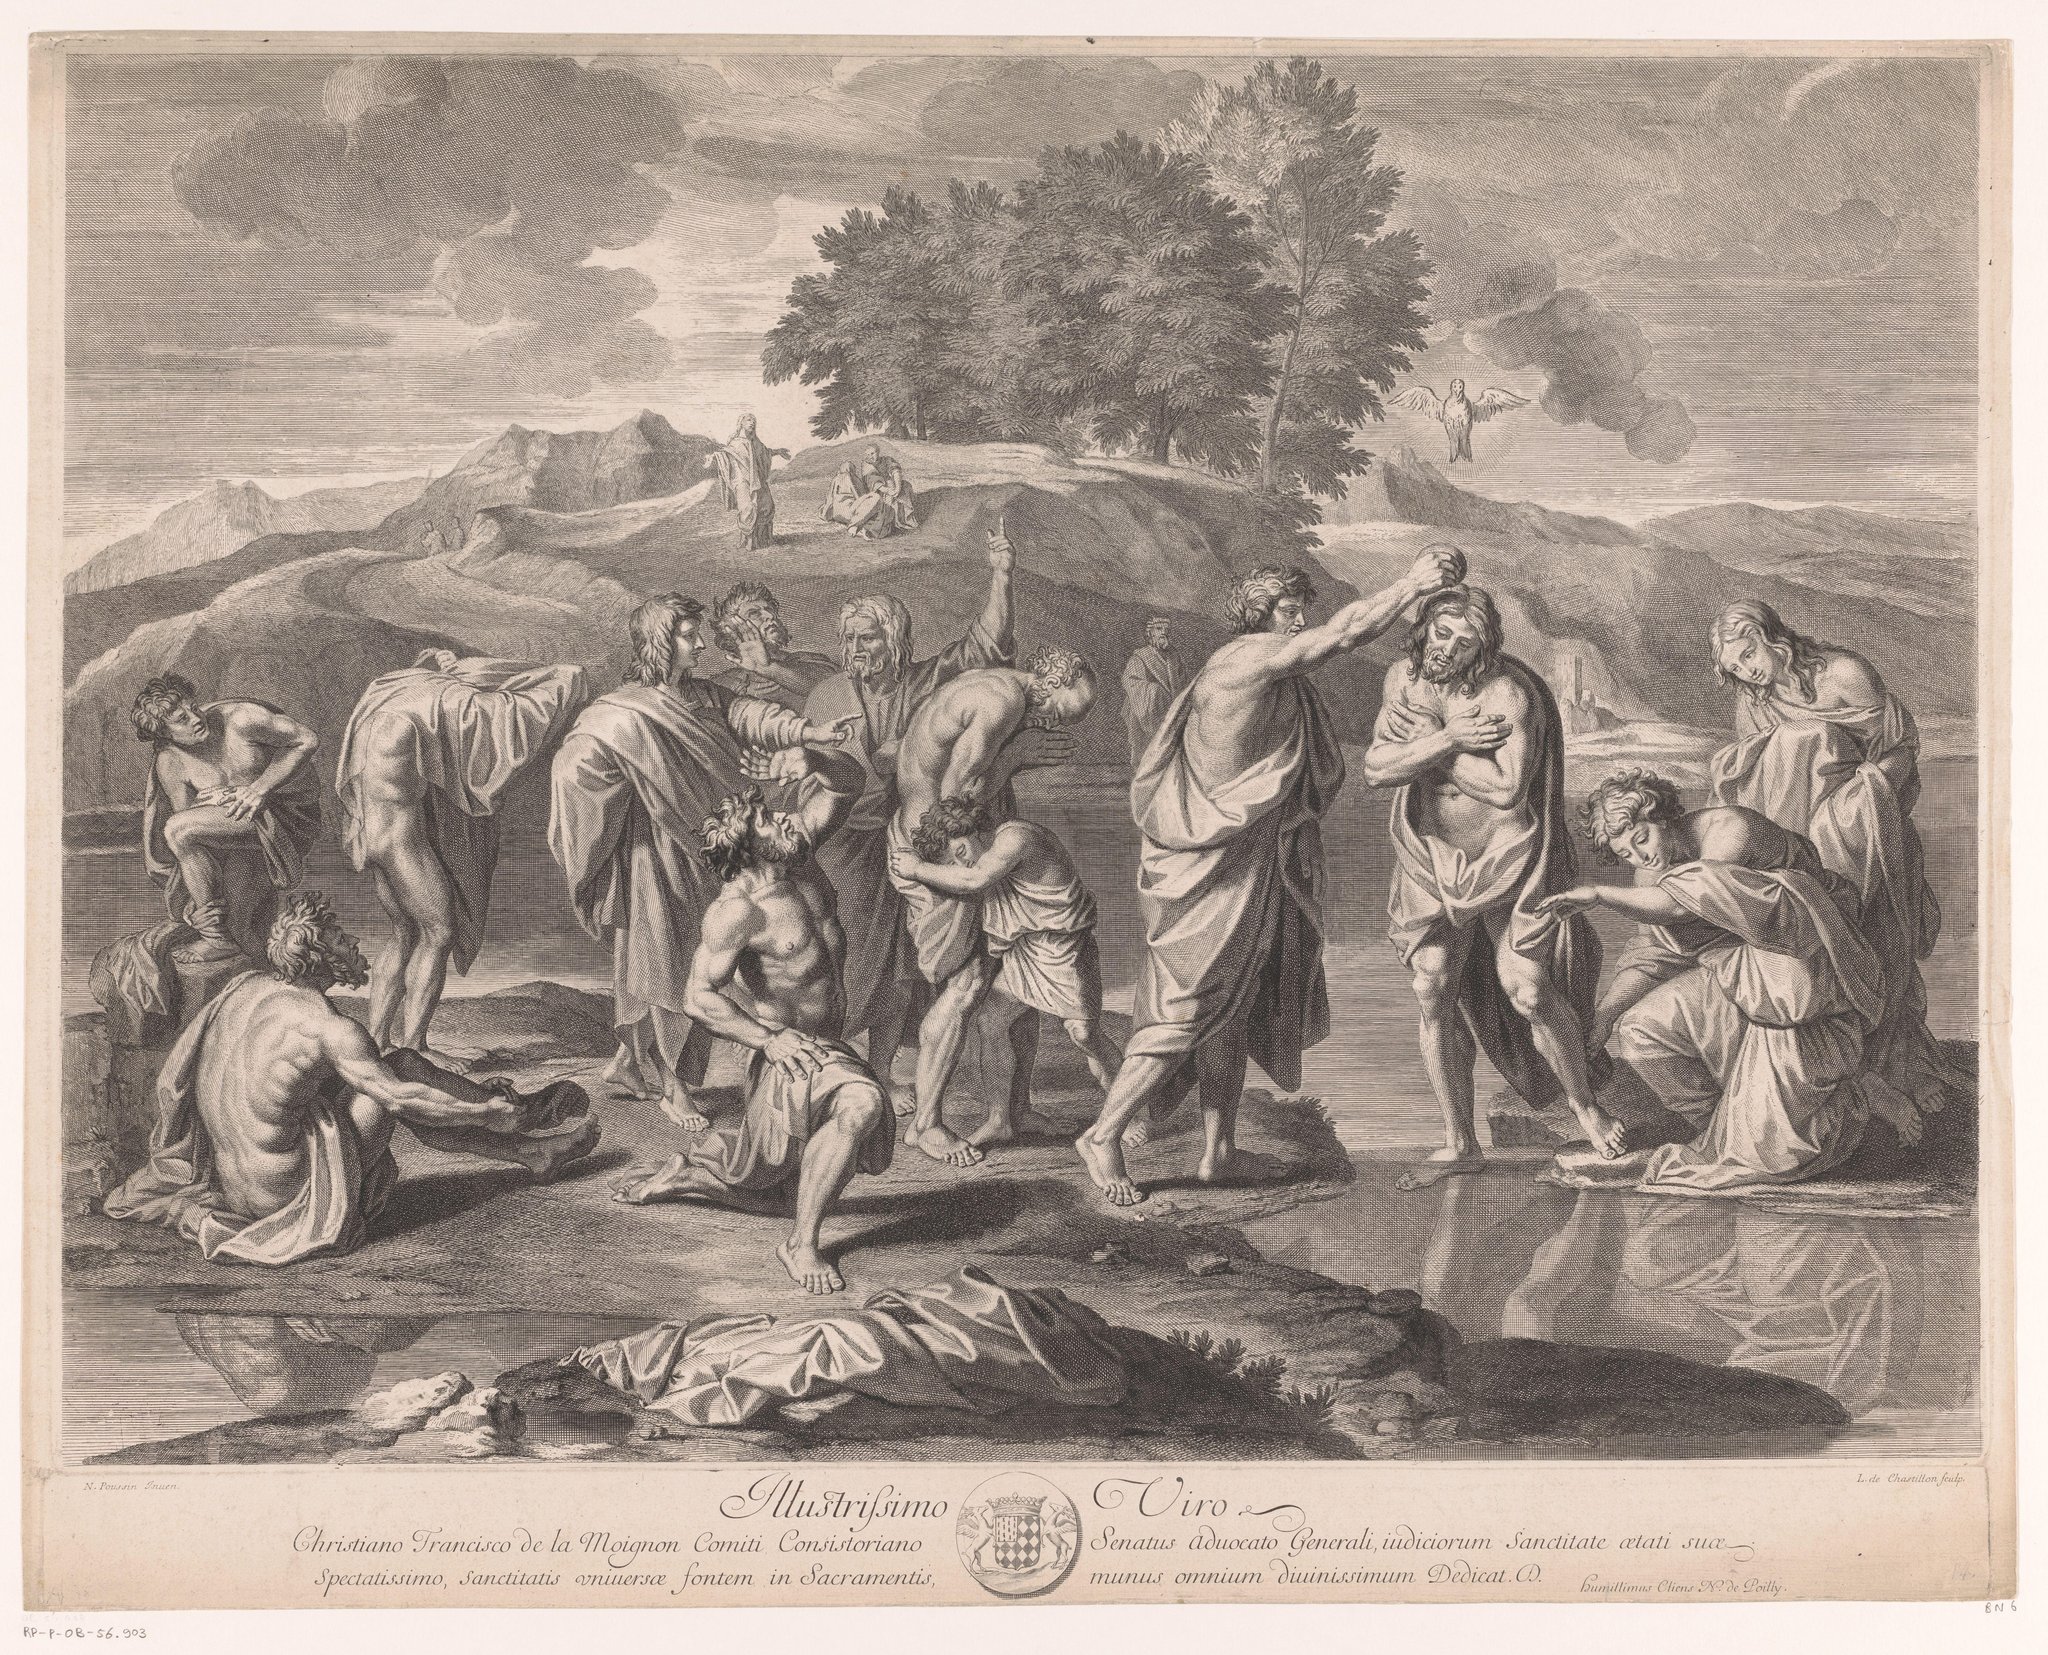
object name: print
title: Zeven sacramenten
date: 1649-1734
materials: paper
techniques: engraving, etching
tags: baptism of christ in the river jordan: john the baptist pouring out water on christ's head: the holy ghost descends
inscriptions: collector's mark: Lugt 240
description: Maakt deel uit van een zevendelige serie met de sacramenten.